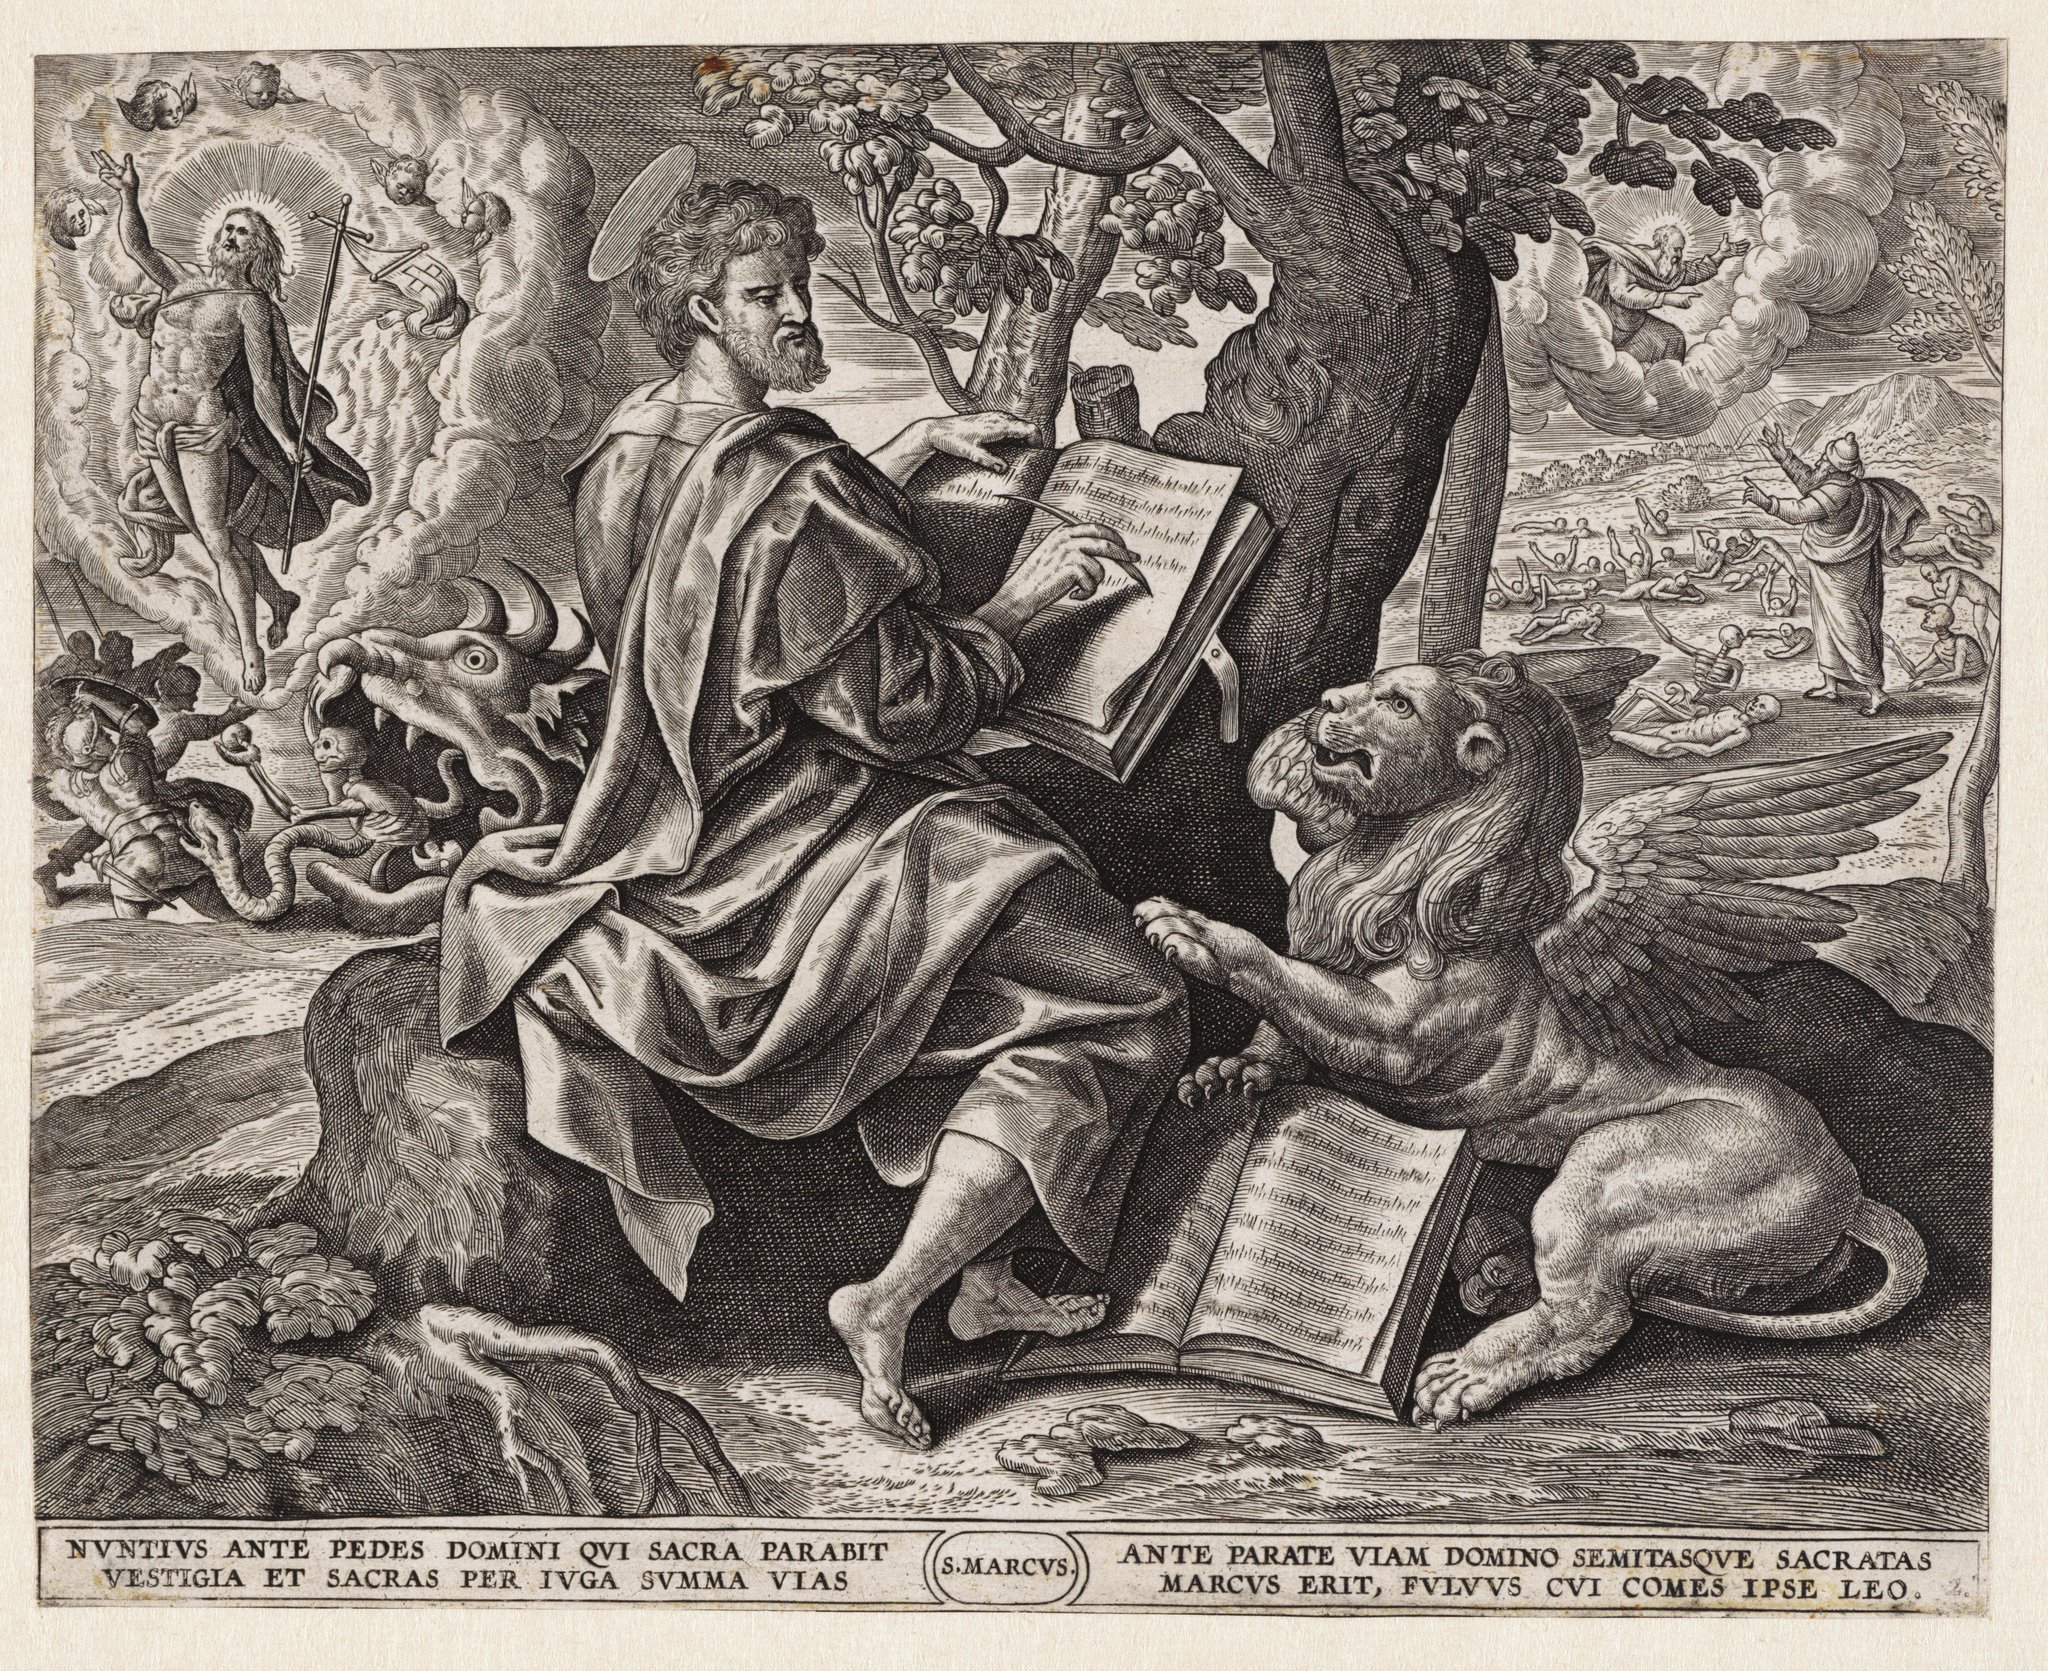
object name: print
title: Evangelist Marcus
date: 1585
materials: paper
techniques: engraving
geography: antwerp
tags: st. mark the evangelist writing the gospel, usually a (winged) lion present, the risen christ (with wounds, but without crown of thorns), sometimes holding the cross, entrance of hell as monstrous mouth (of leviathan), ezekiel's vision of the valley of the dry bones (ezekiel 37:1-10)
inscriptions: collector's mark: Lugt 2760, collector's mark: Lugt 2228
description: De evangelist Marcus schrijft zijn evangelie onder een boom. Naast hem de gevleugelde leeuw. Links op de achtergrond de herrezen Christus, bij de opening van de hel (de gapende muil van het monster). Rechts op de achtergrond het visioen van de profeet Ezechiël van het dal van dorre beenderen. De profeet kijkt omhoog naar God de Vader. In de marge een vierregelig onderschrift, in twee kolommen, in het Latijn.